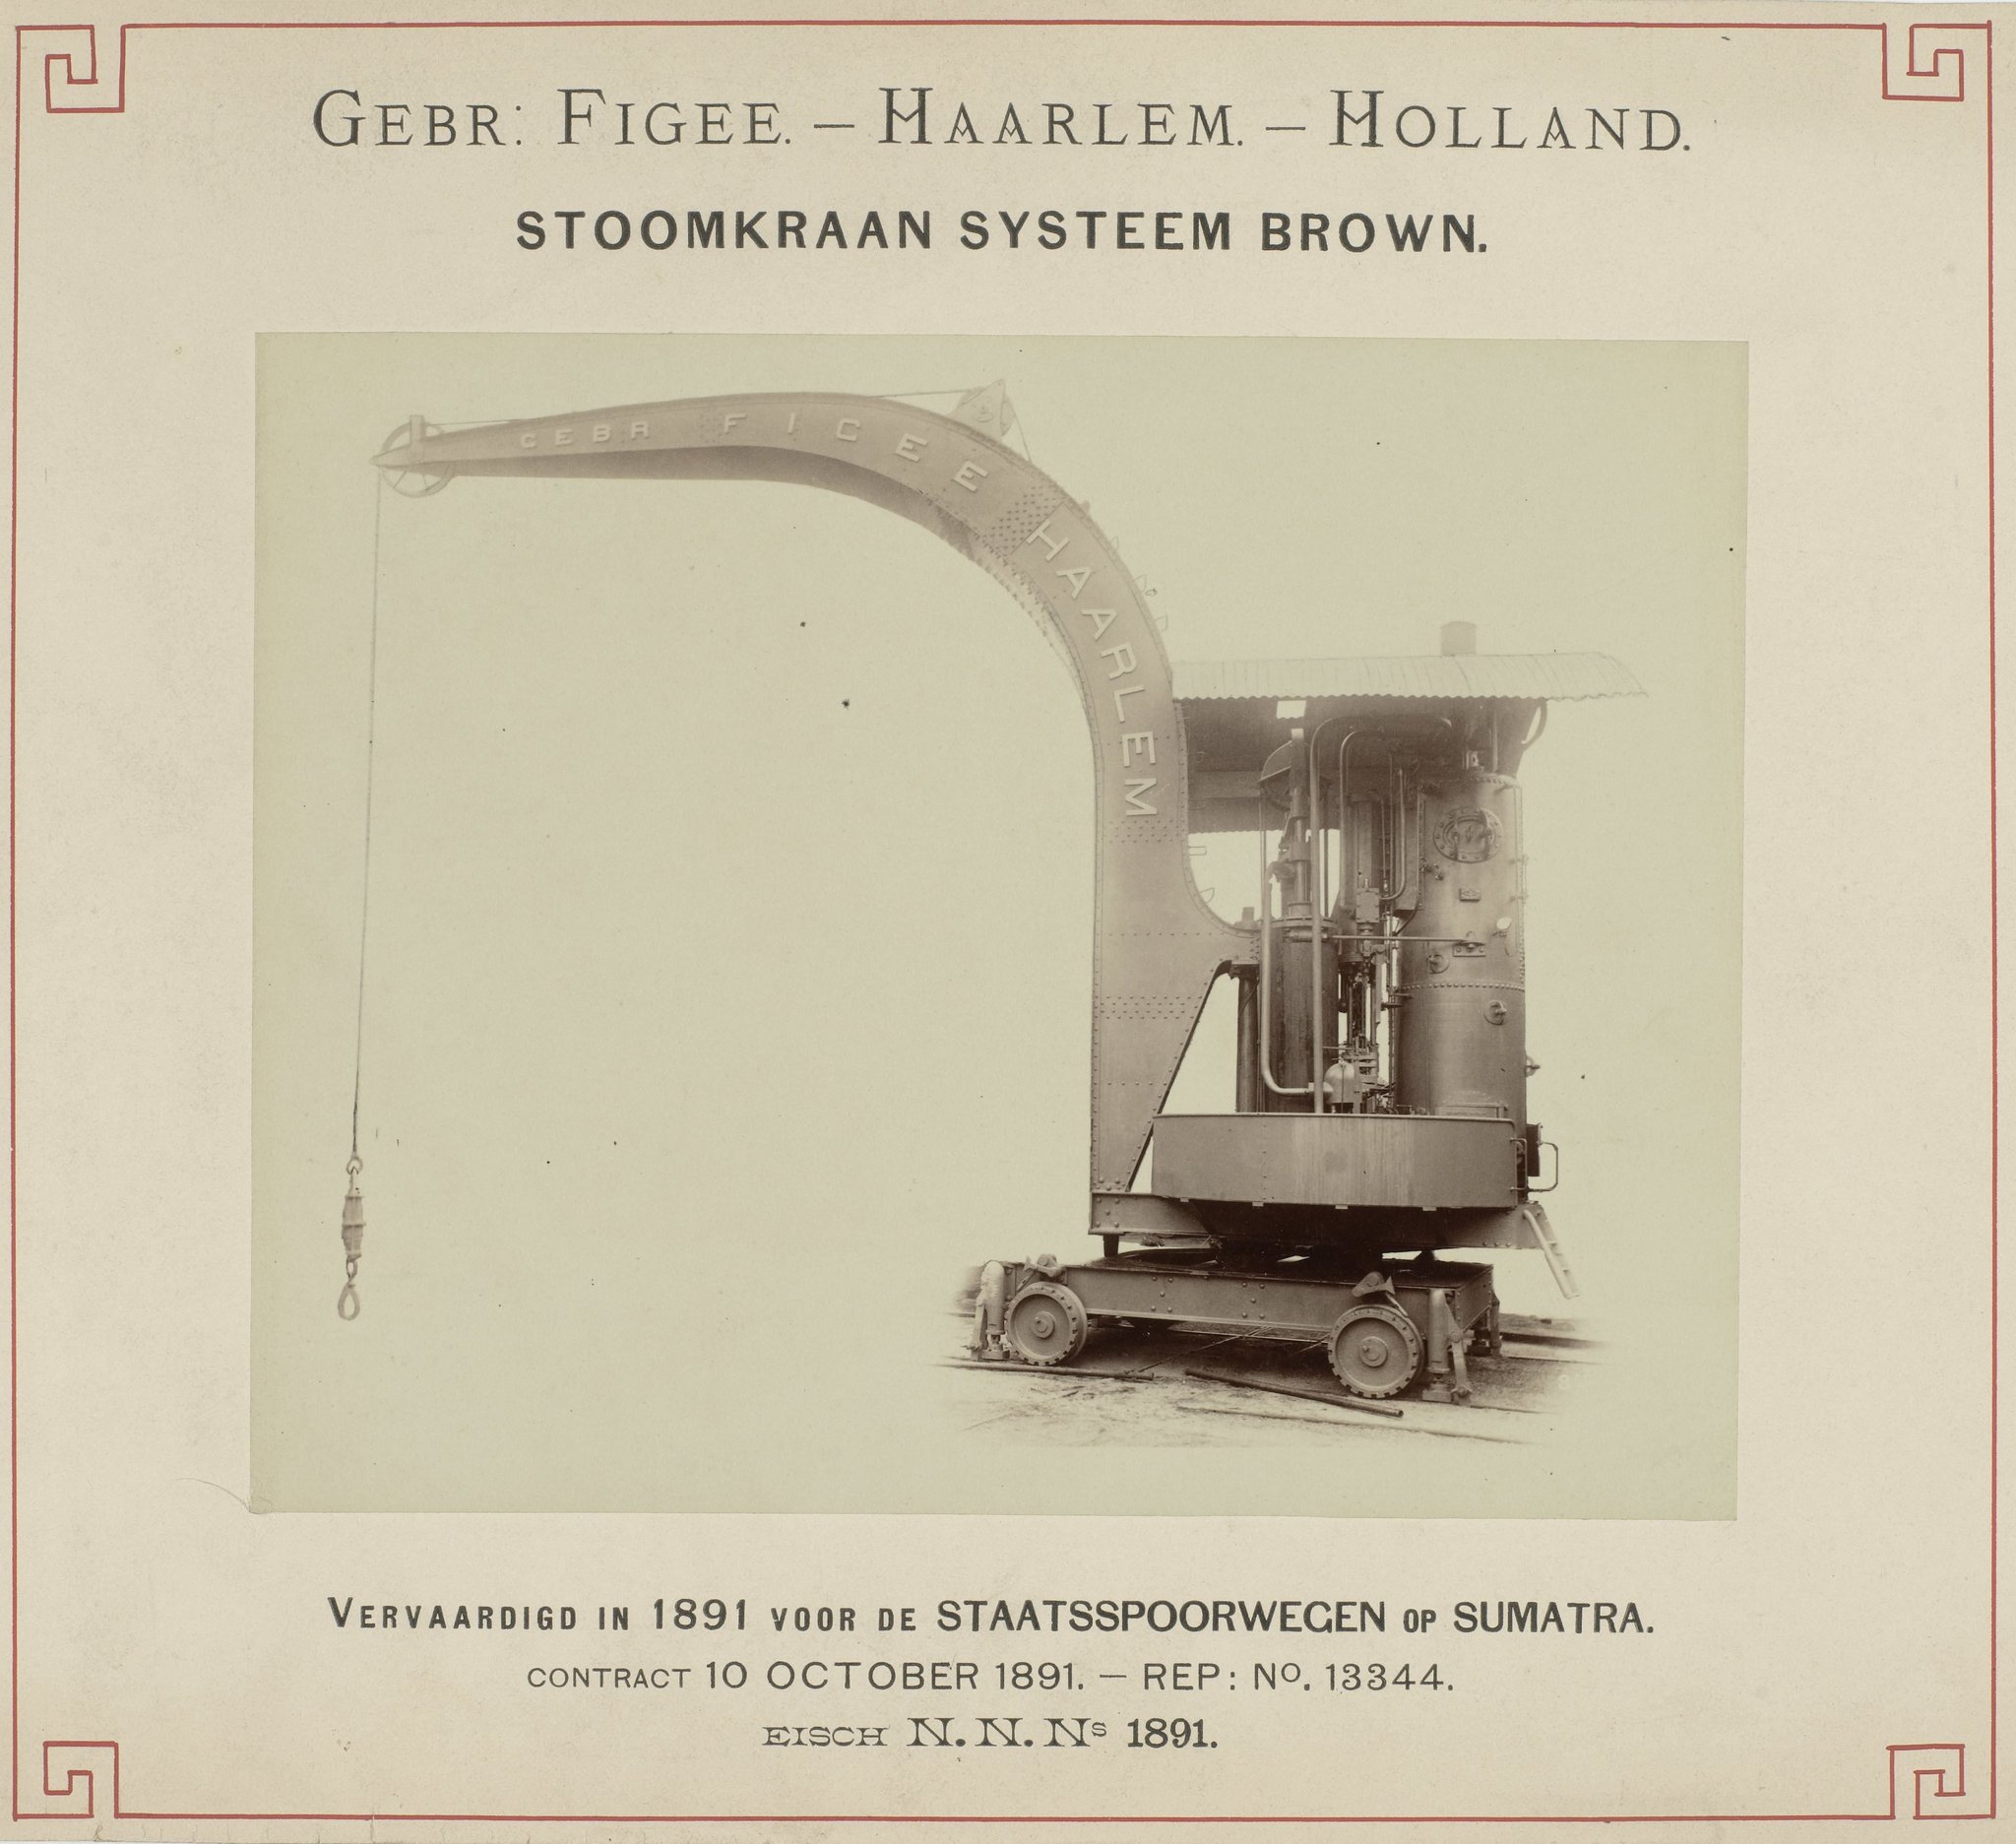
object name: photograph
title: Stoomkraansysteem Brown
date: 1891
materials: cardboard, paper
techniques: photography, printing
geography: haarlem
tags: indië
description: Foto van een kraan, op karton geplakt, in rood gelijnd kader met tekst onder en boven waarop opdrachtgever e.d. Vervaardigd voor Staatsspoorwegen Sumatra. Opschrift; b. en o.: 'Gebr. Figee - Haarlem - Holland'.